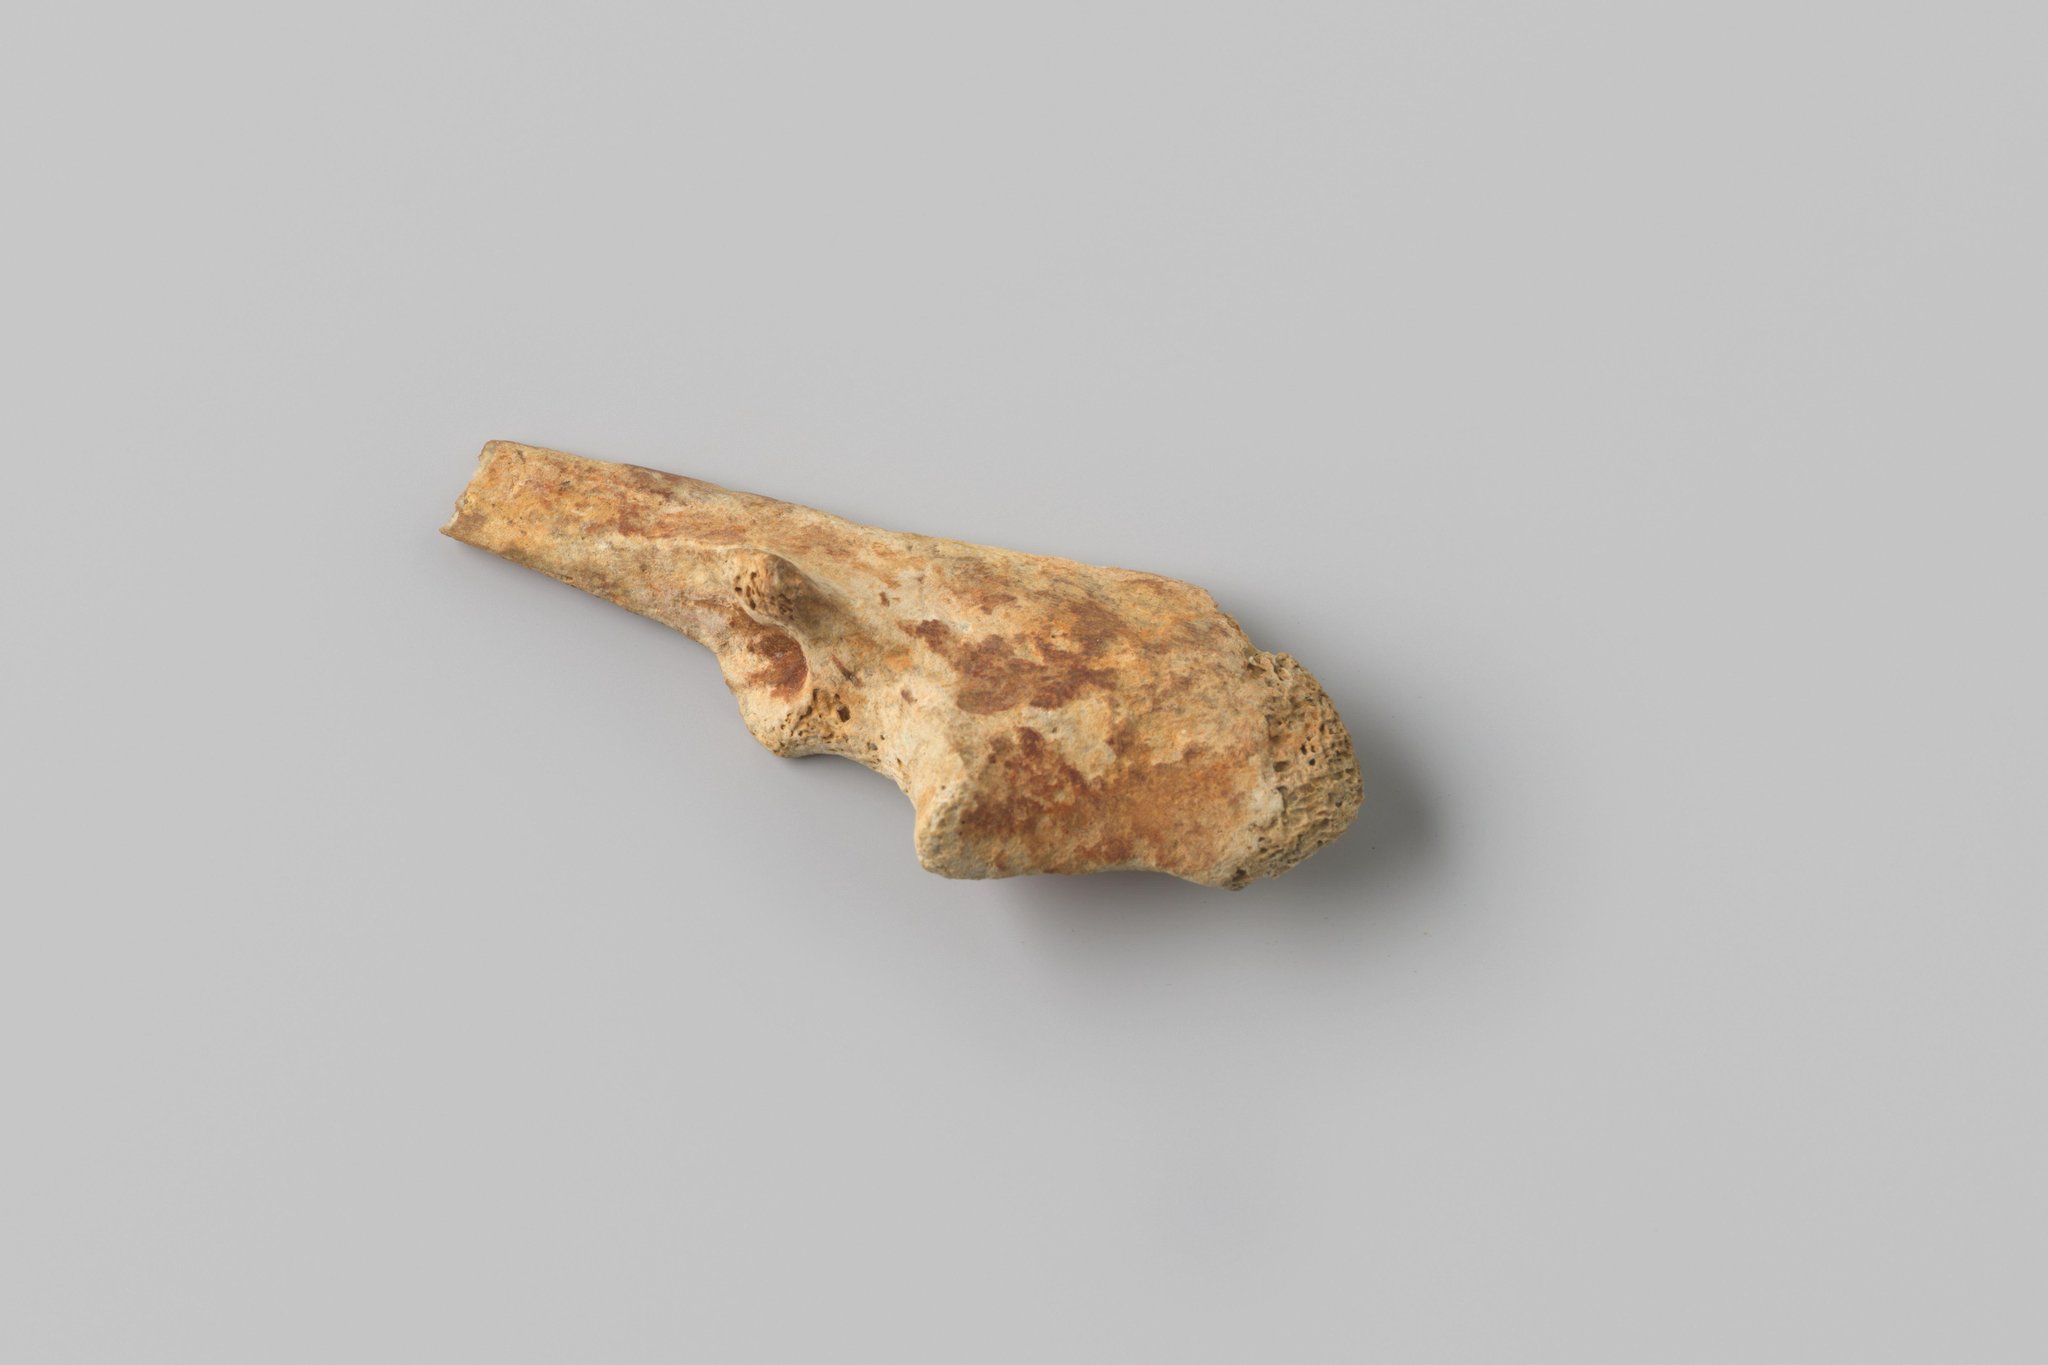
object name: bone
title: Schapen- of geitenbot uit het wrak van de Oost-Indiëvaarder Hollandia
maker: Anonymous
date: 1700-1743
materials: bone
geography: netherlands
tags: verenigde oostindische compagnie, hollandia (schip), annet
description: Sheep or goatbone; fragm of ulna (part of foreleg), proximal end, olecranon fused.